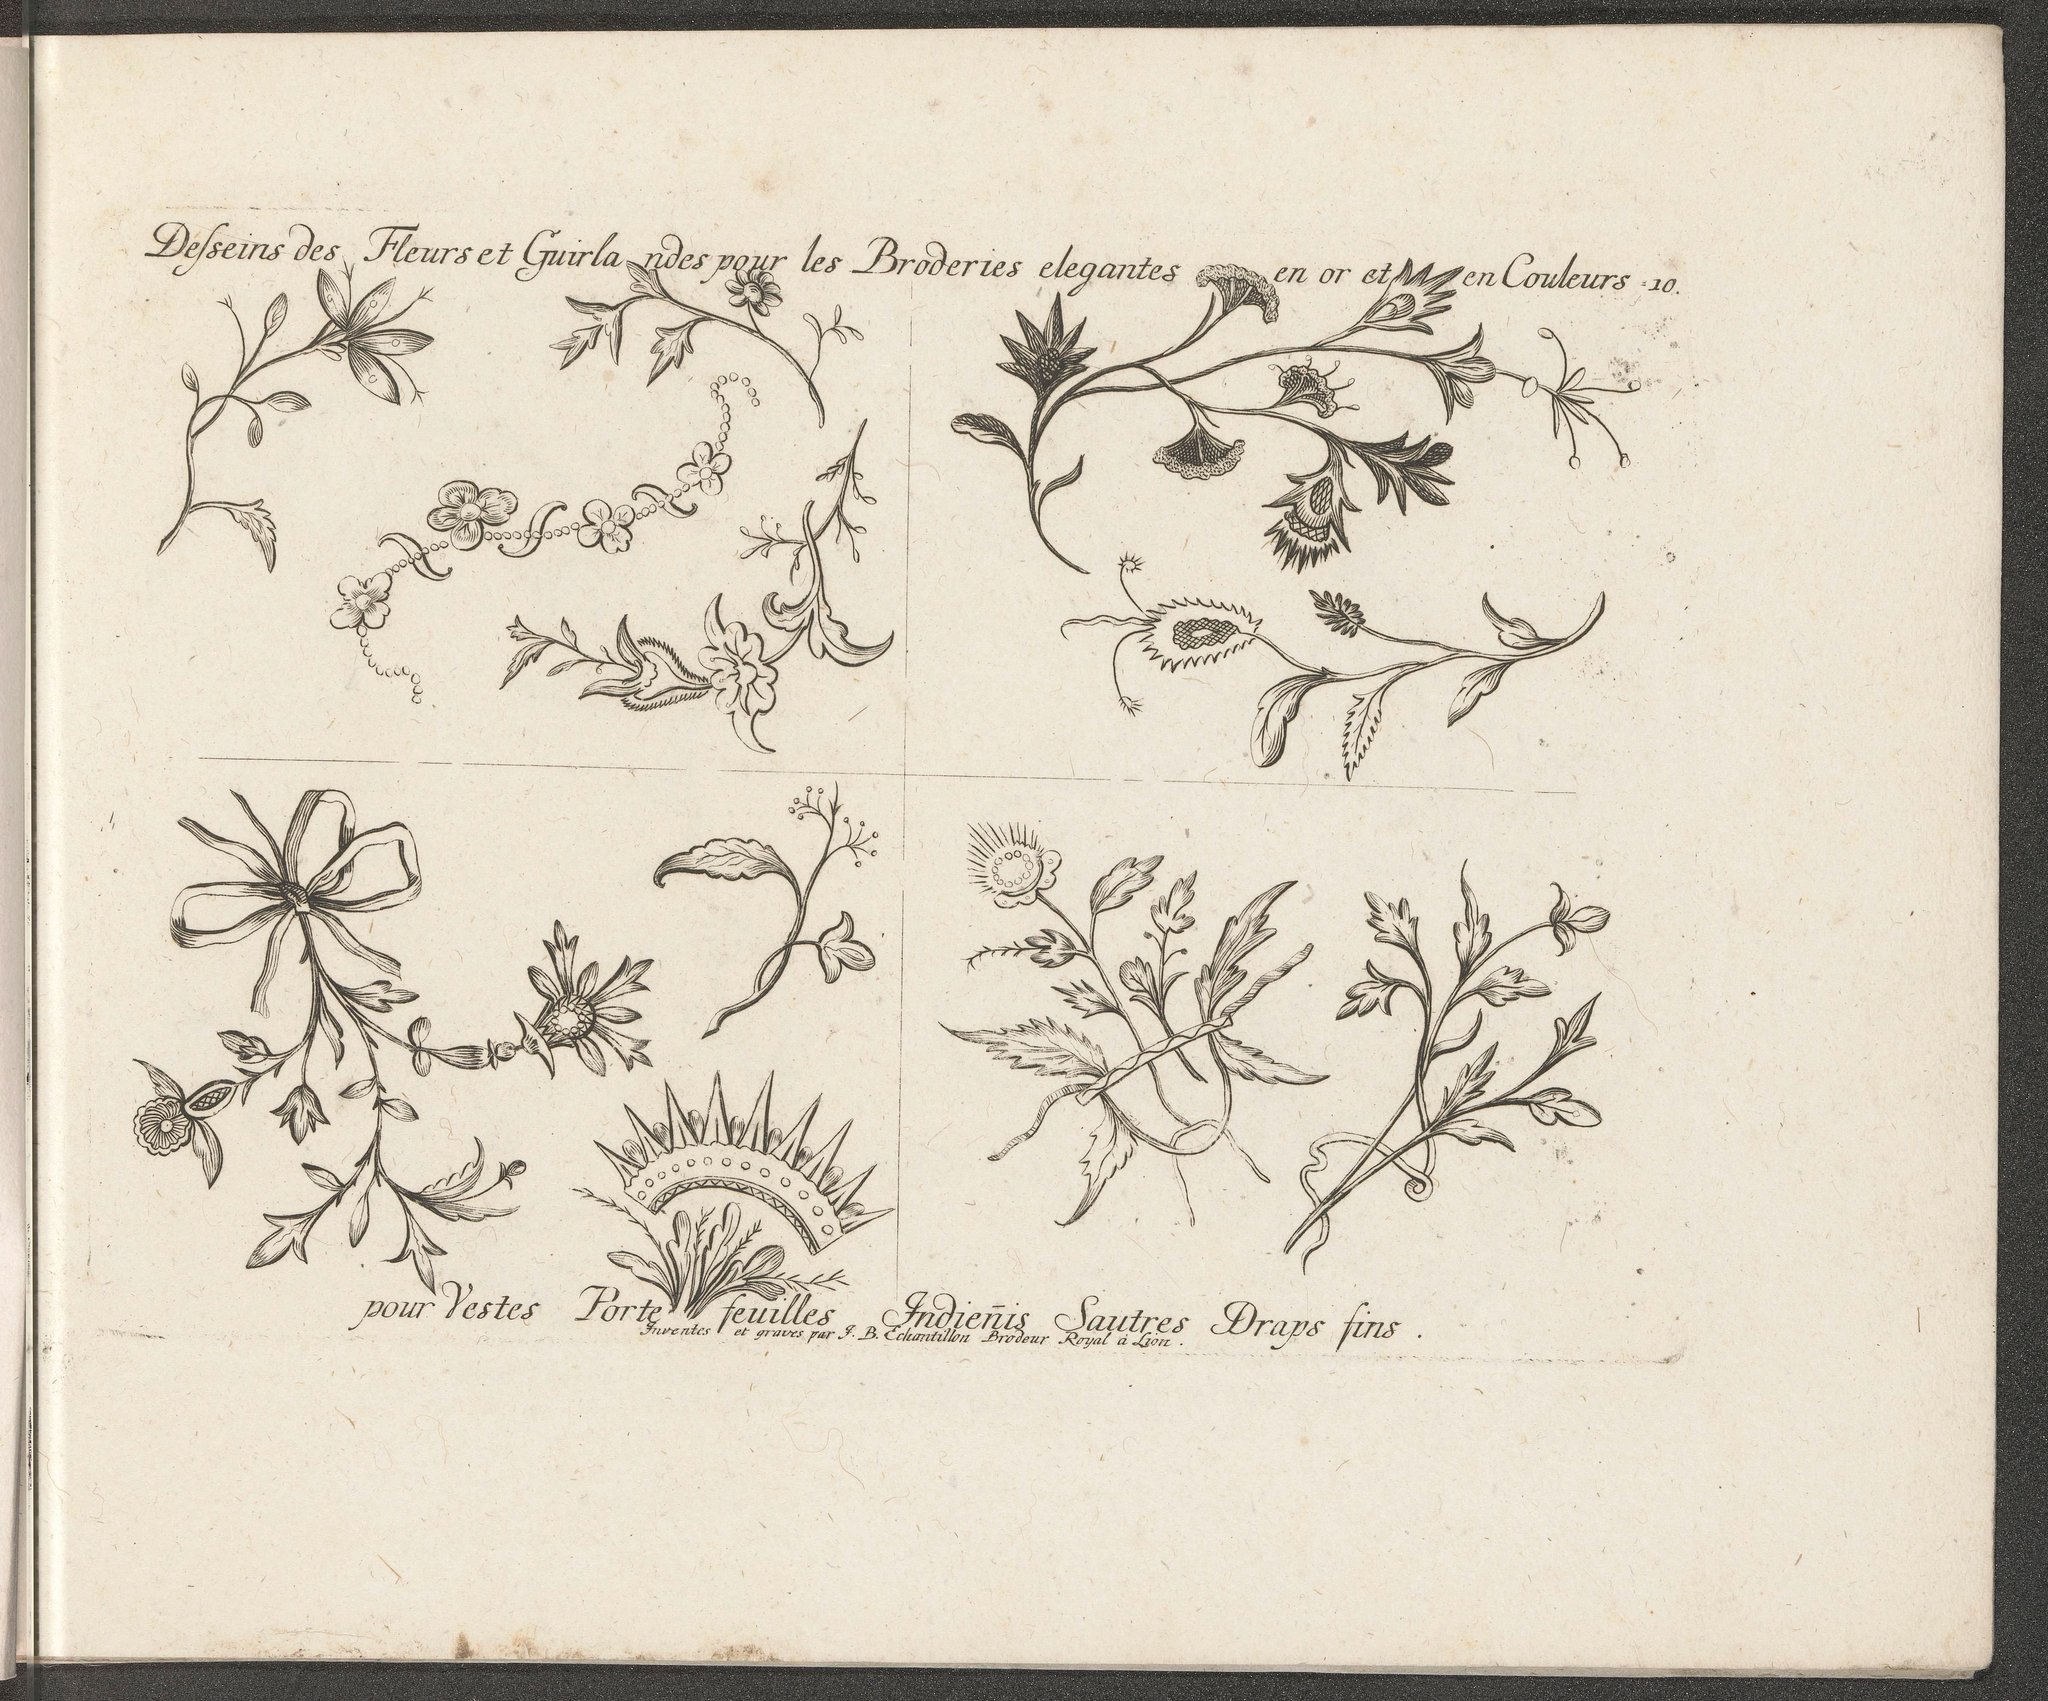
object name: ornament print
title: Ontwerpen voor borduurwerk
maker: jean baptiste echantillon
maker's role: print maker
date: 1784-1785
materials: paper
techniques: etching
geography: lyon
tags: embroidery (ornamentation)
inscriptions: collector's mark: Lugt 2760, collector's mark: Lugt 2228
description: Diverse bloemenranken, in vier compartimenten verdeeld.